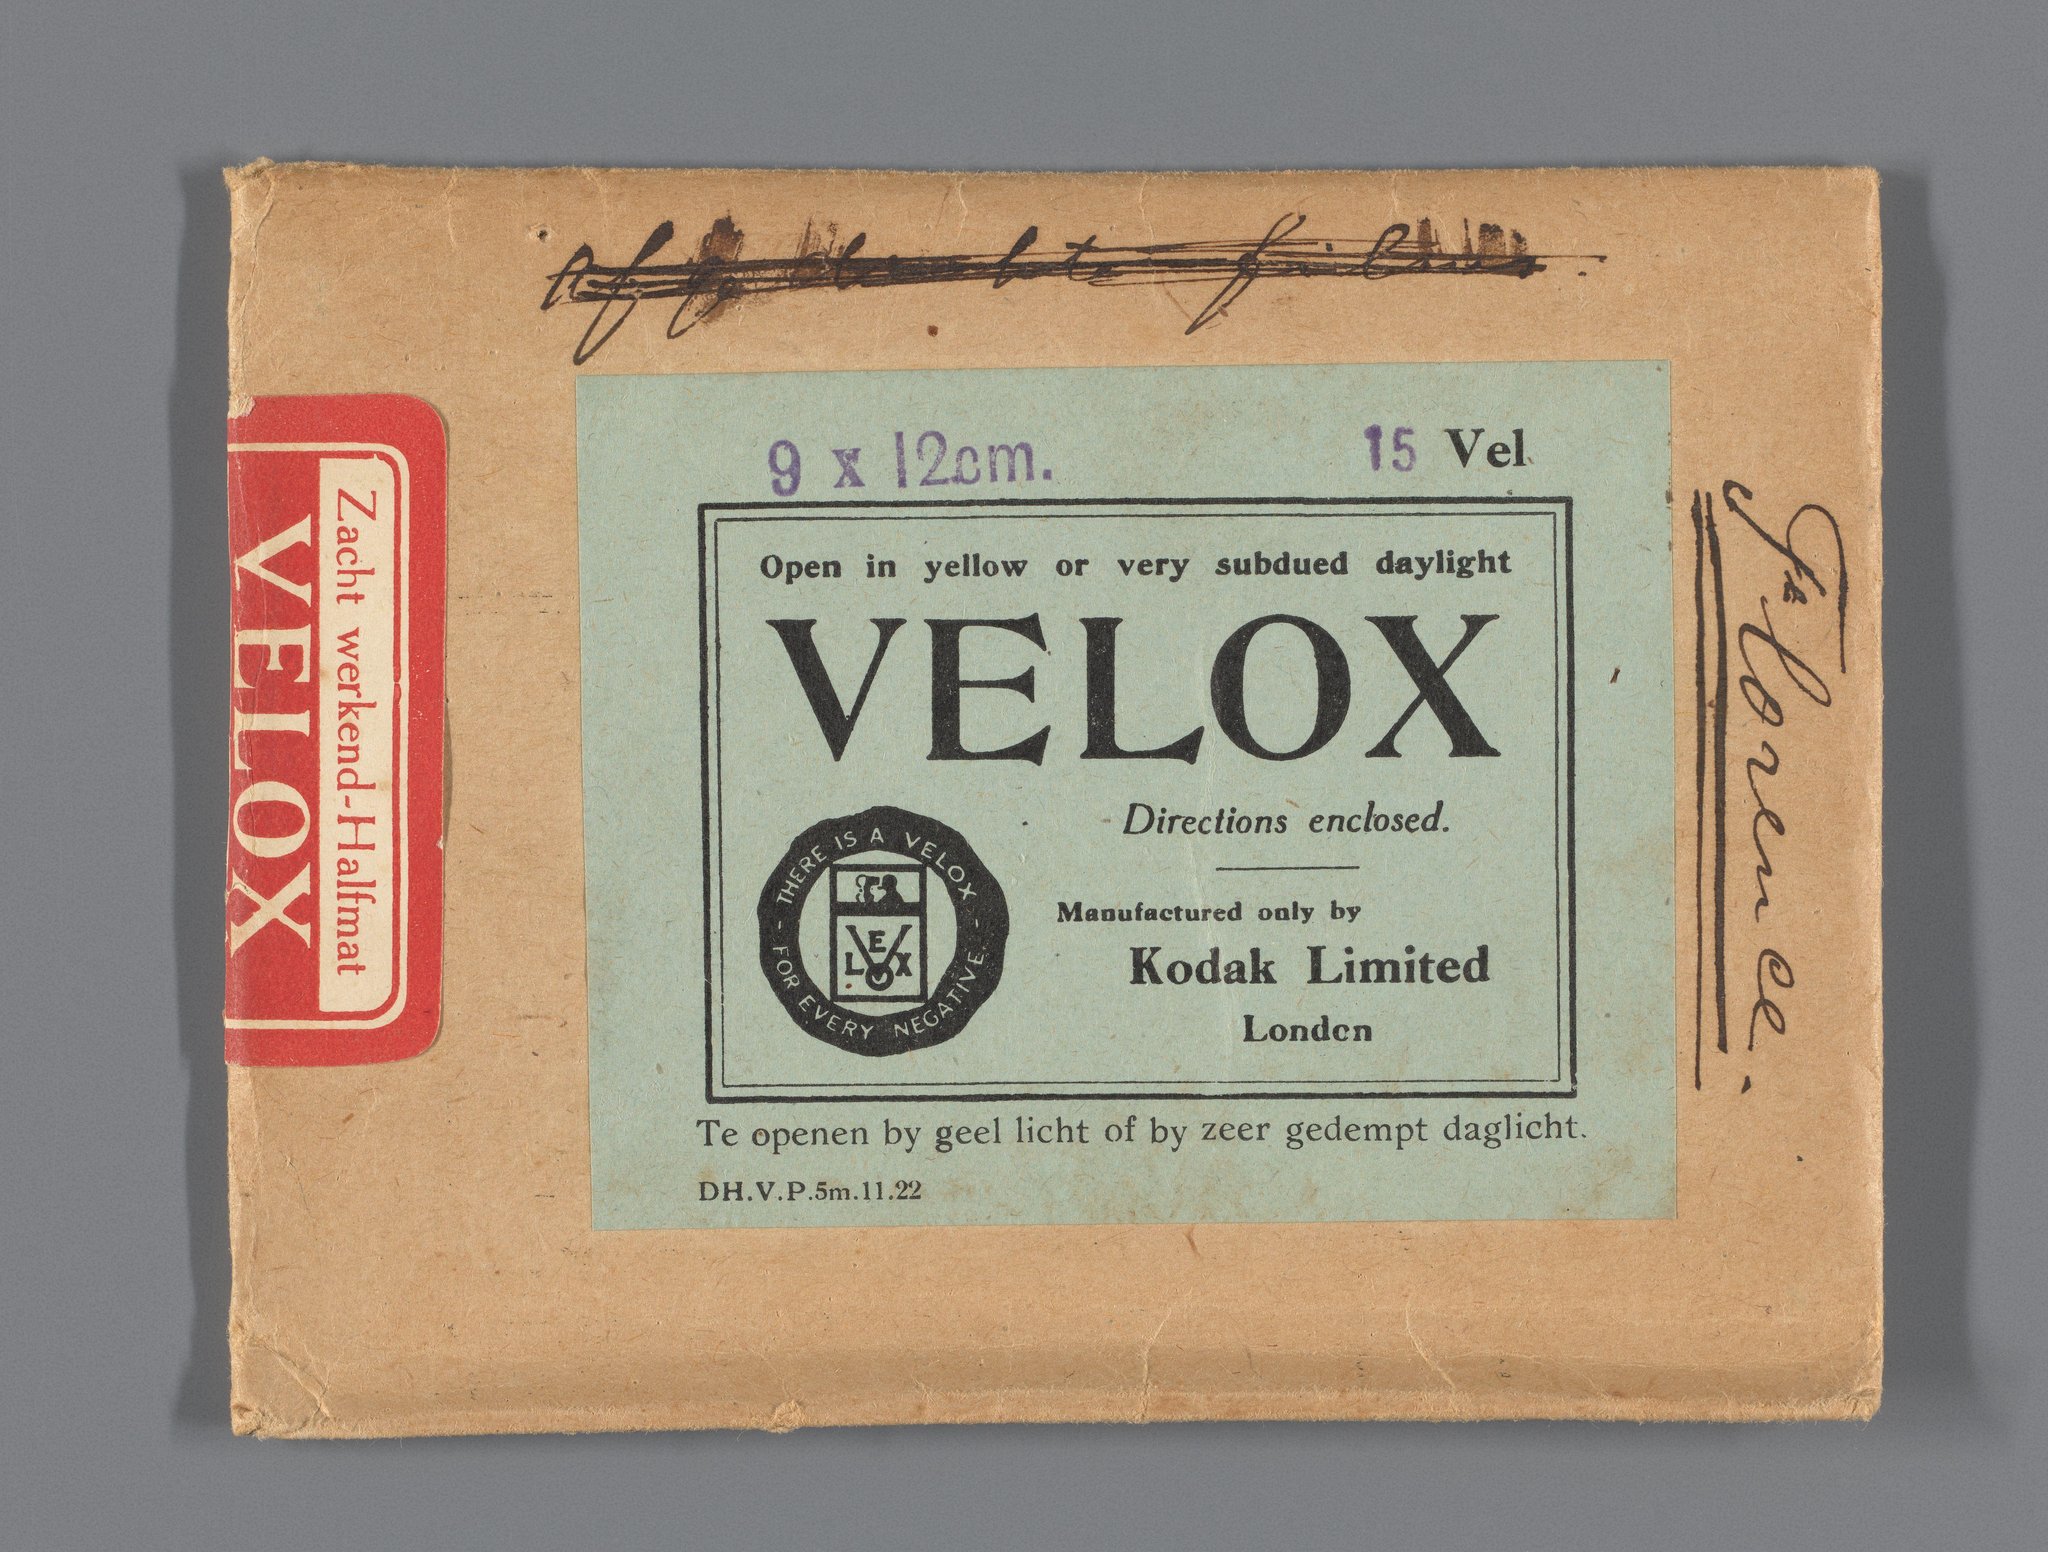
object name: envelope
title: Envelop voor fotopapier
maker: Anonymous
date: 1907-1935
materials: paper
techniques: printing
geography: europe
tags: florence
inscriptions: inscription: ‘Florence’